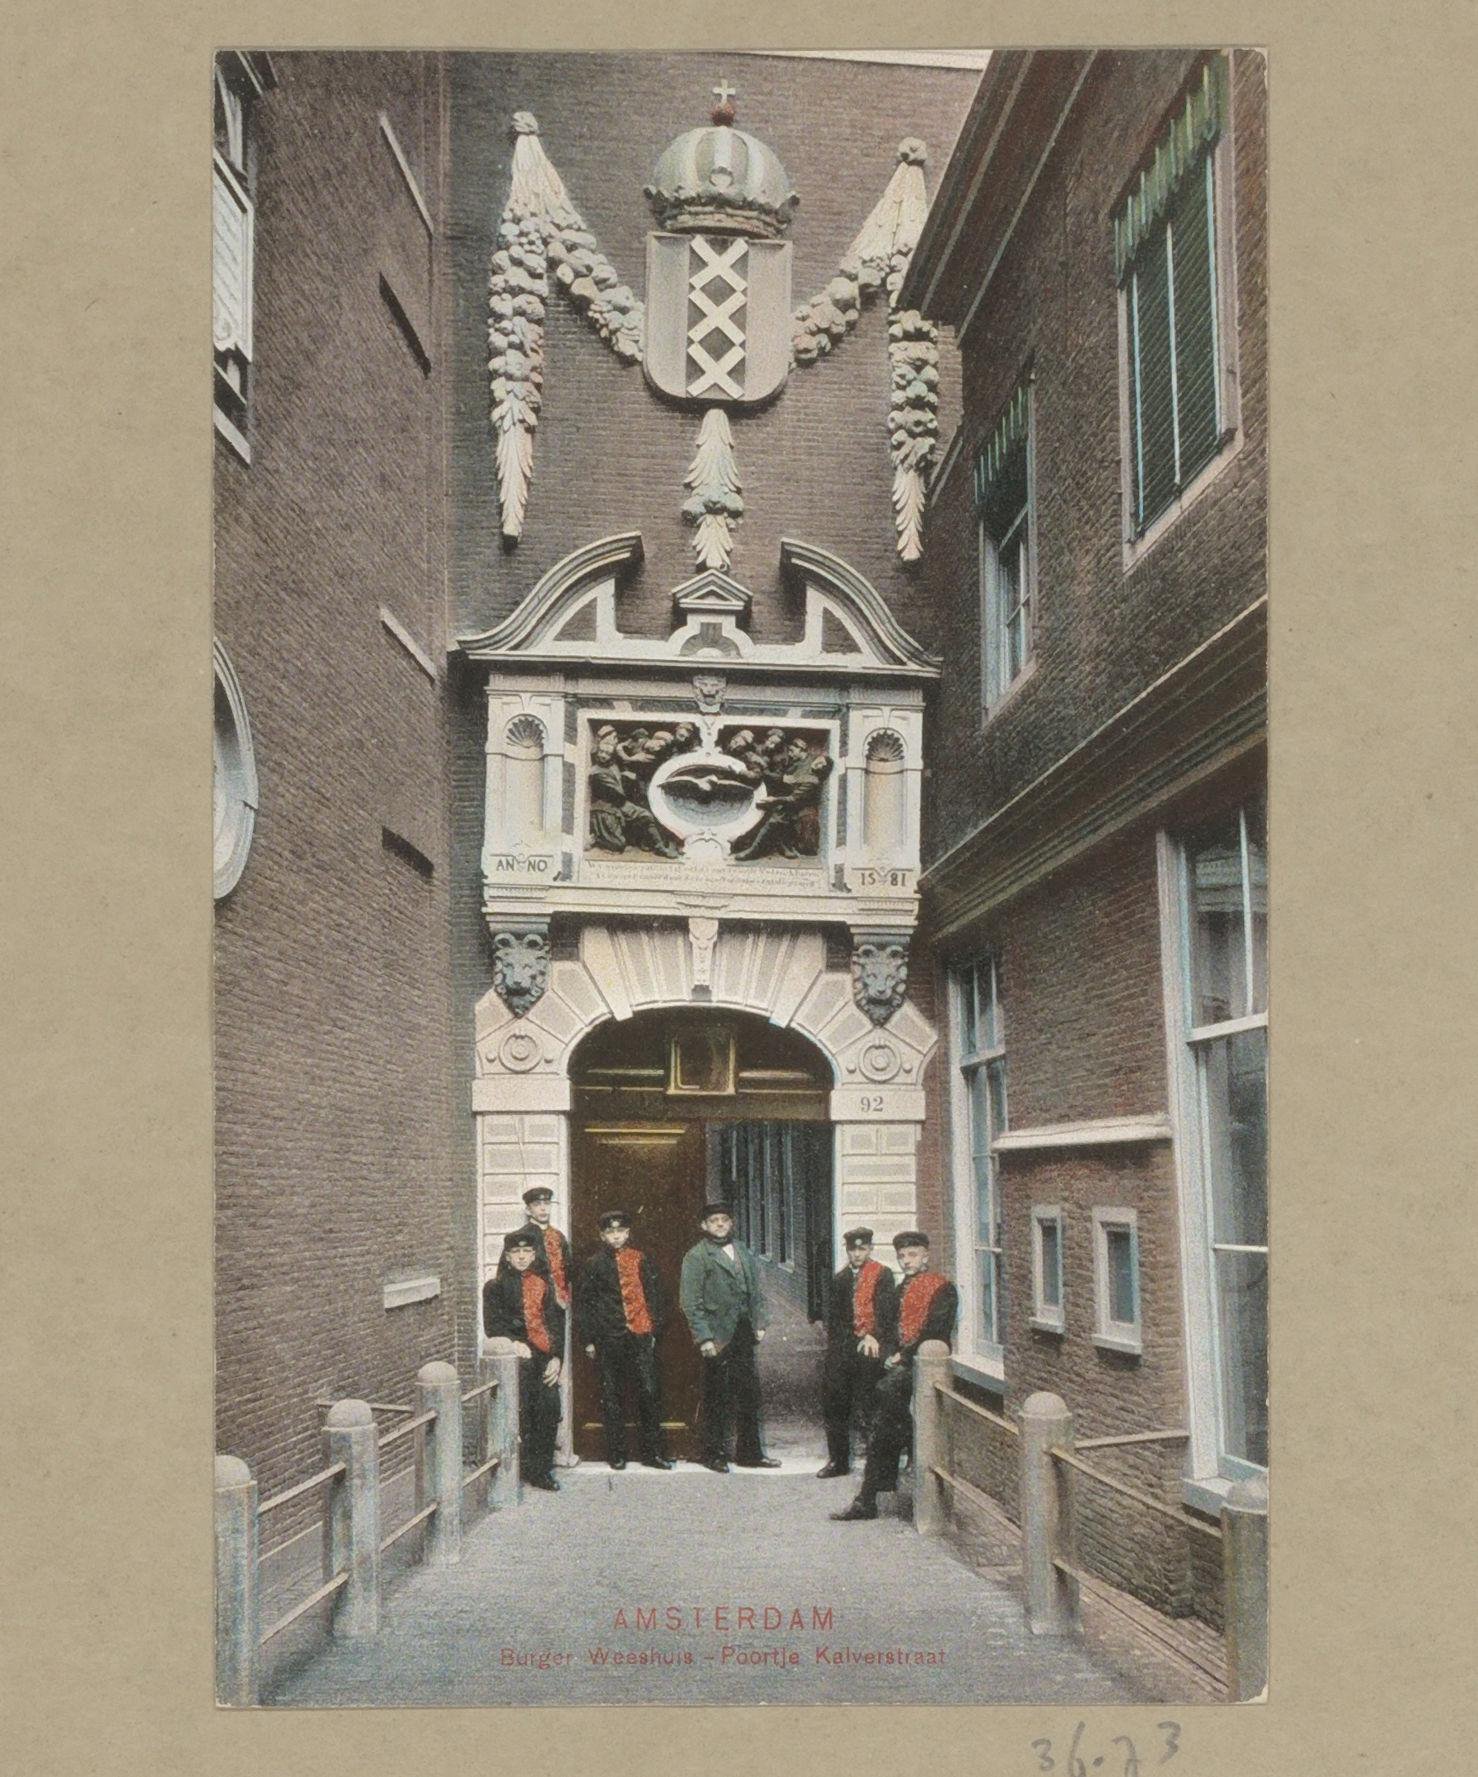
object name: photomechanical print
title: Amsterdam Burger Weeshuis - Poortje Kalverstraat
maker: Anonymous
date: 1890-1920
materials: cardboard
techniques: four-color autotype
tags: orphanage, orphans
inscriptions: collector's mark: Lugt 1641b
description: Onderwerpsrubriek binnen de Atlas Amsterdam: Armwezen en liefdadige instellingen: I. Stadsinrichtingen: Burgerweeshuis.